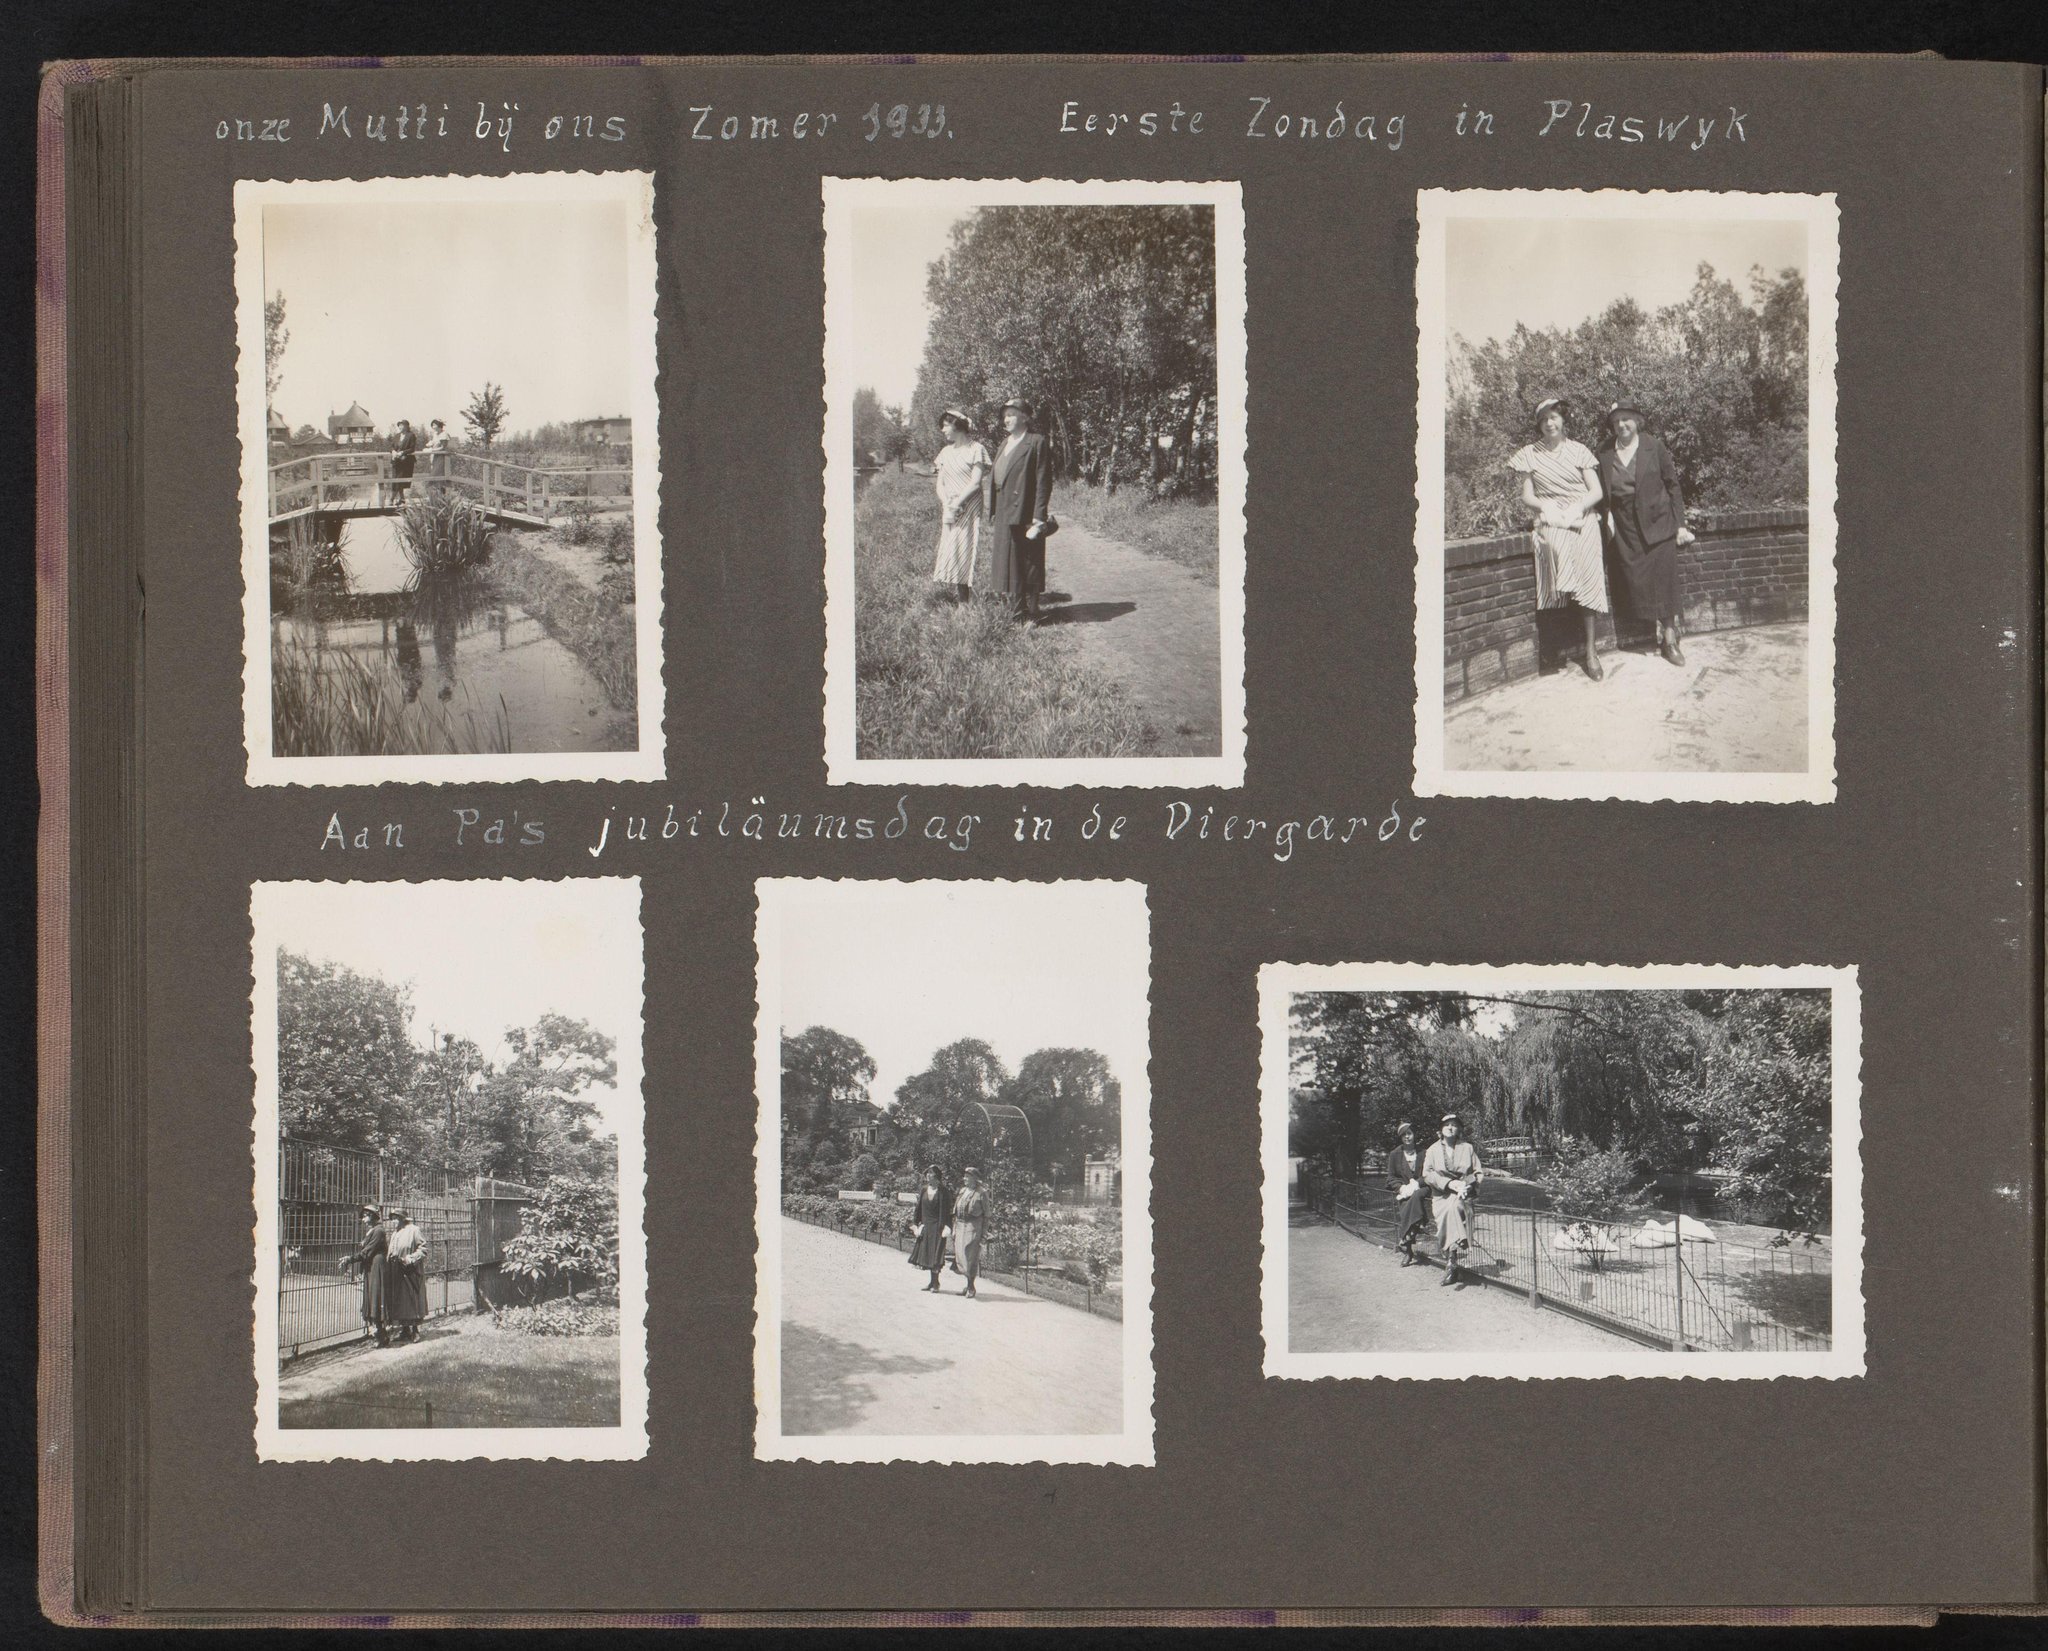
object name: photograph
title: Berti Hoppe en haar moeder in Plaswijck en in Diergaarde Blijdorp te Rotterdam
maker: herman besselaar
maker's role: taalkundige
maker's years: 1904-1994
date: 1933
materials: cardboard, paper, photographic support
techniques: gelatin silver print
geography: rotterdam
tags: mother and daughter(s) (family group), zoo (as place of recreation), rotterdam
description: Zes foto's gemaakt tijdens het bezoek van de moeder van Berti Hoppe in de zomer van 1933. Deze pagina maakt deel uit van een album.